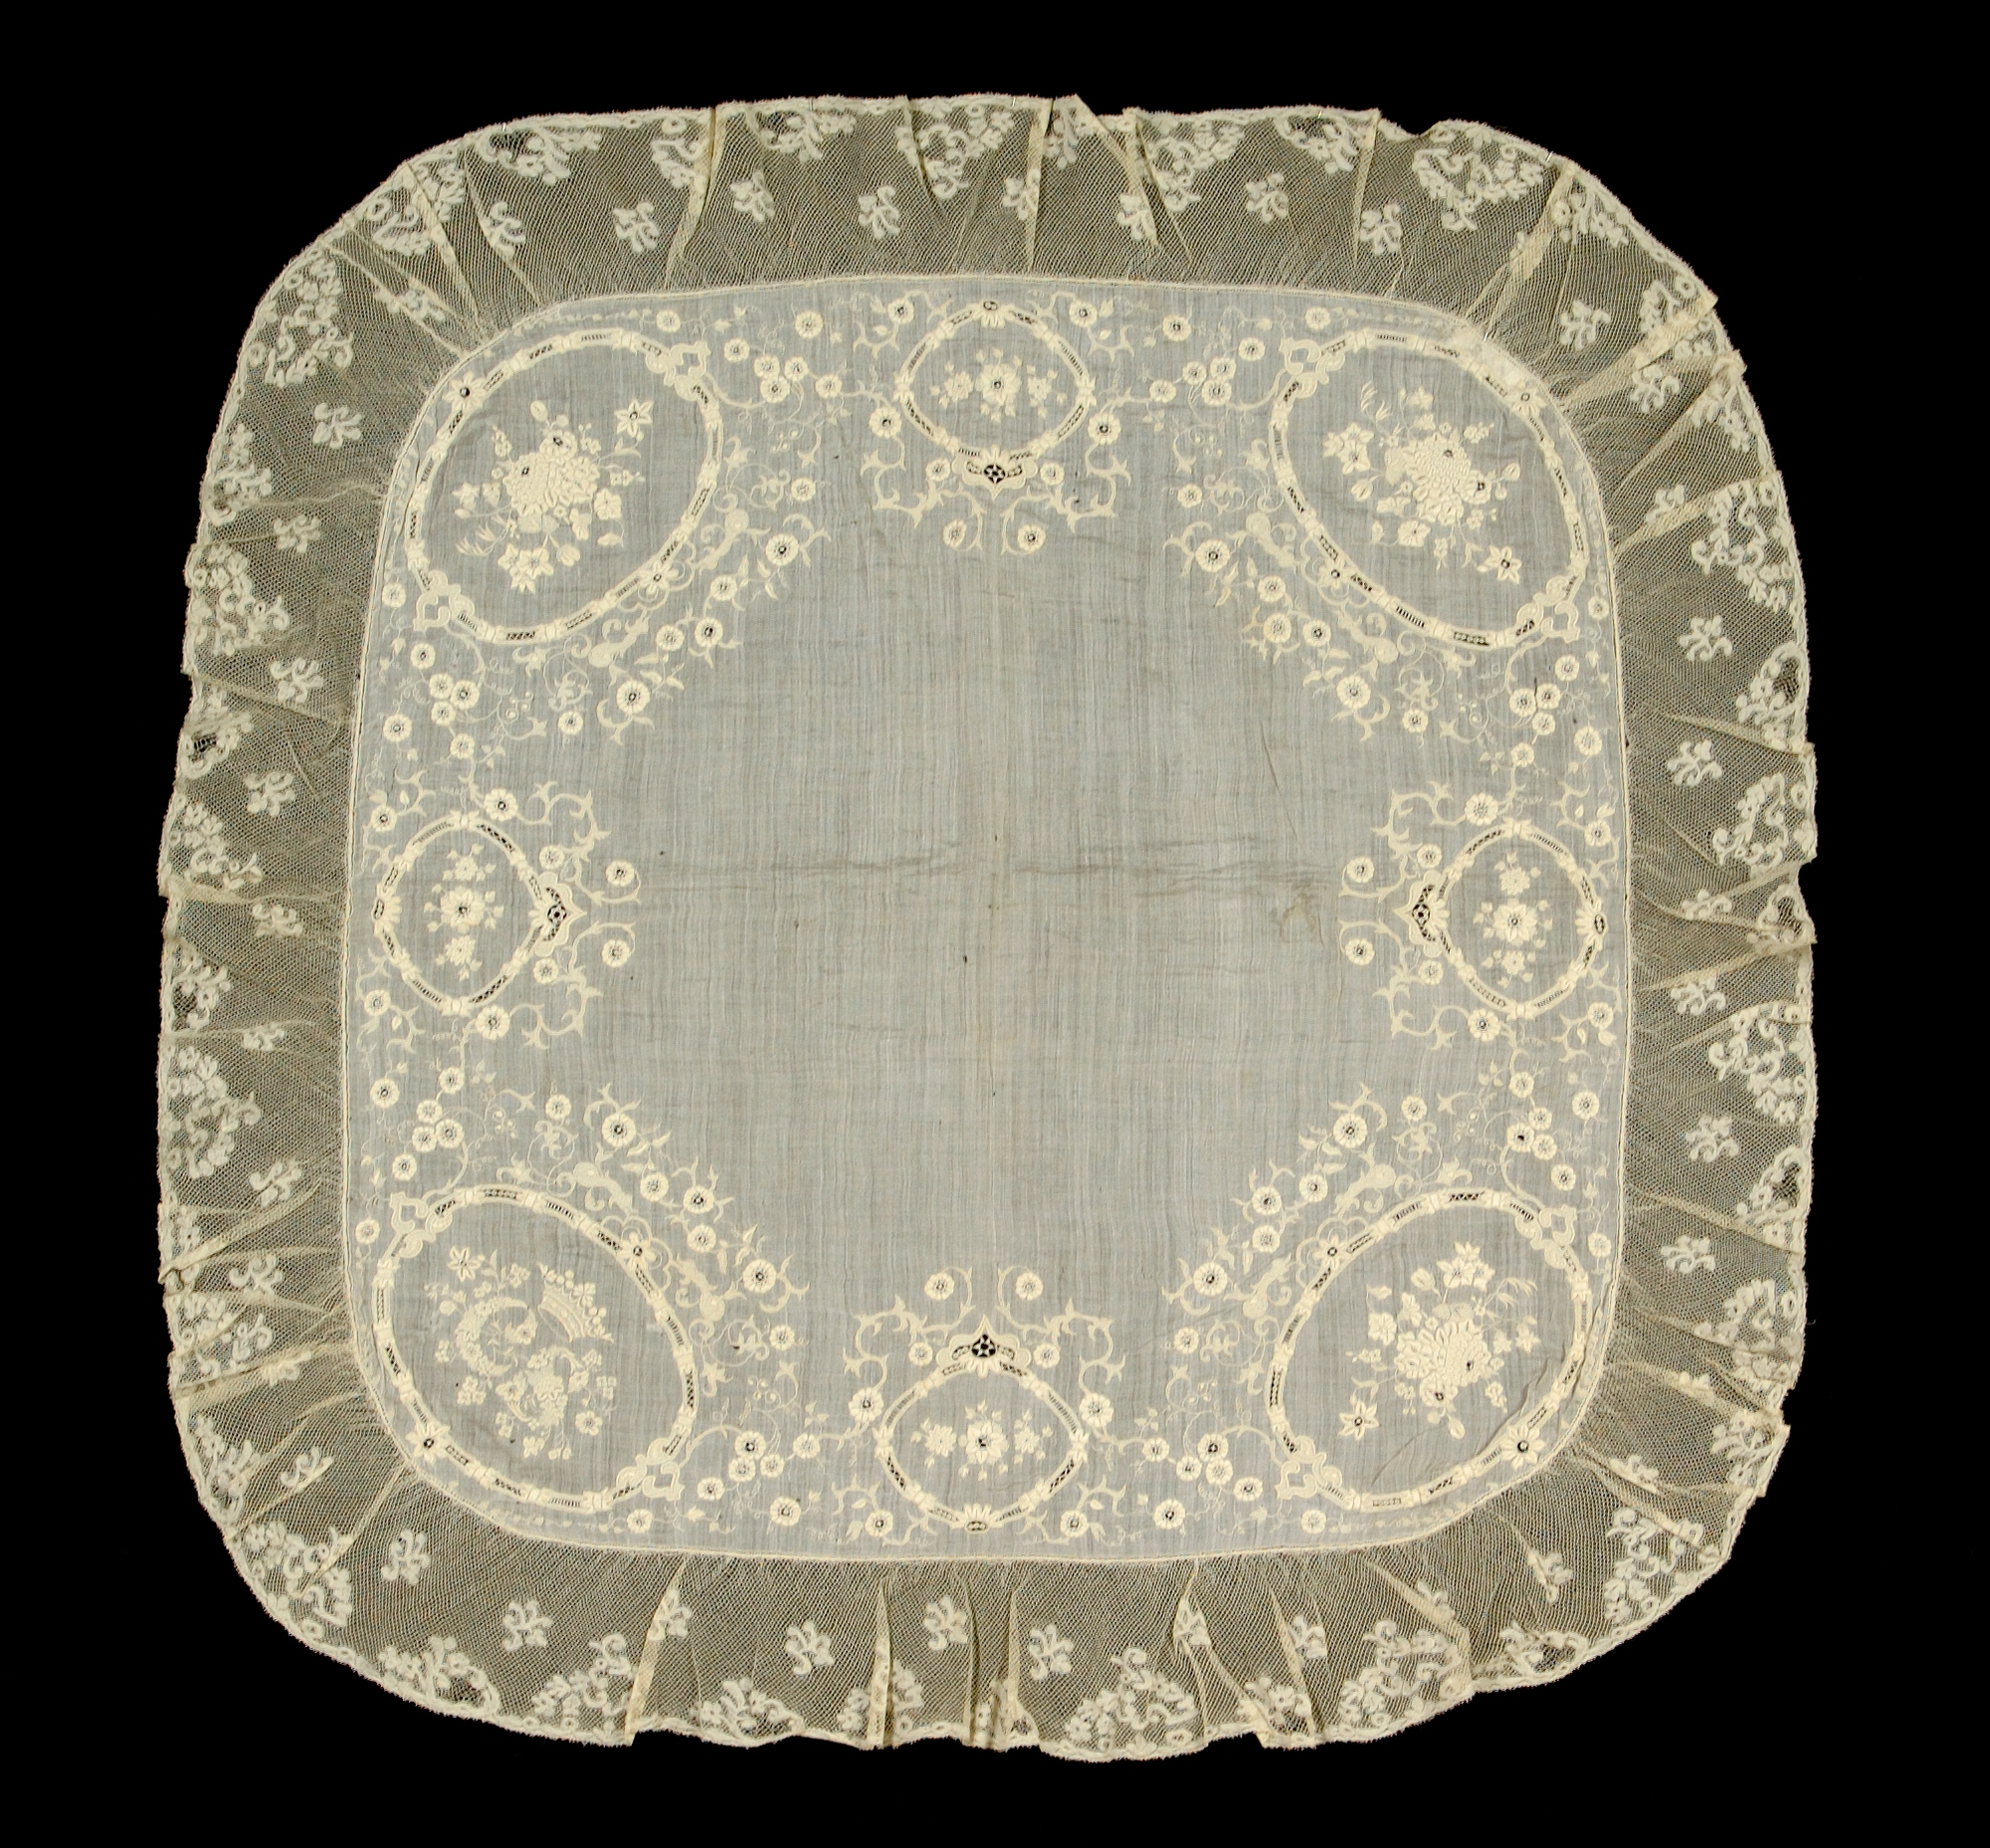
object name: handkerchief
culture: belgian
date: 1840-1860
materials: linen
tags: flowers